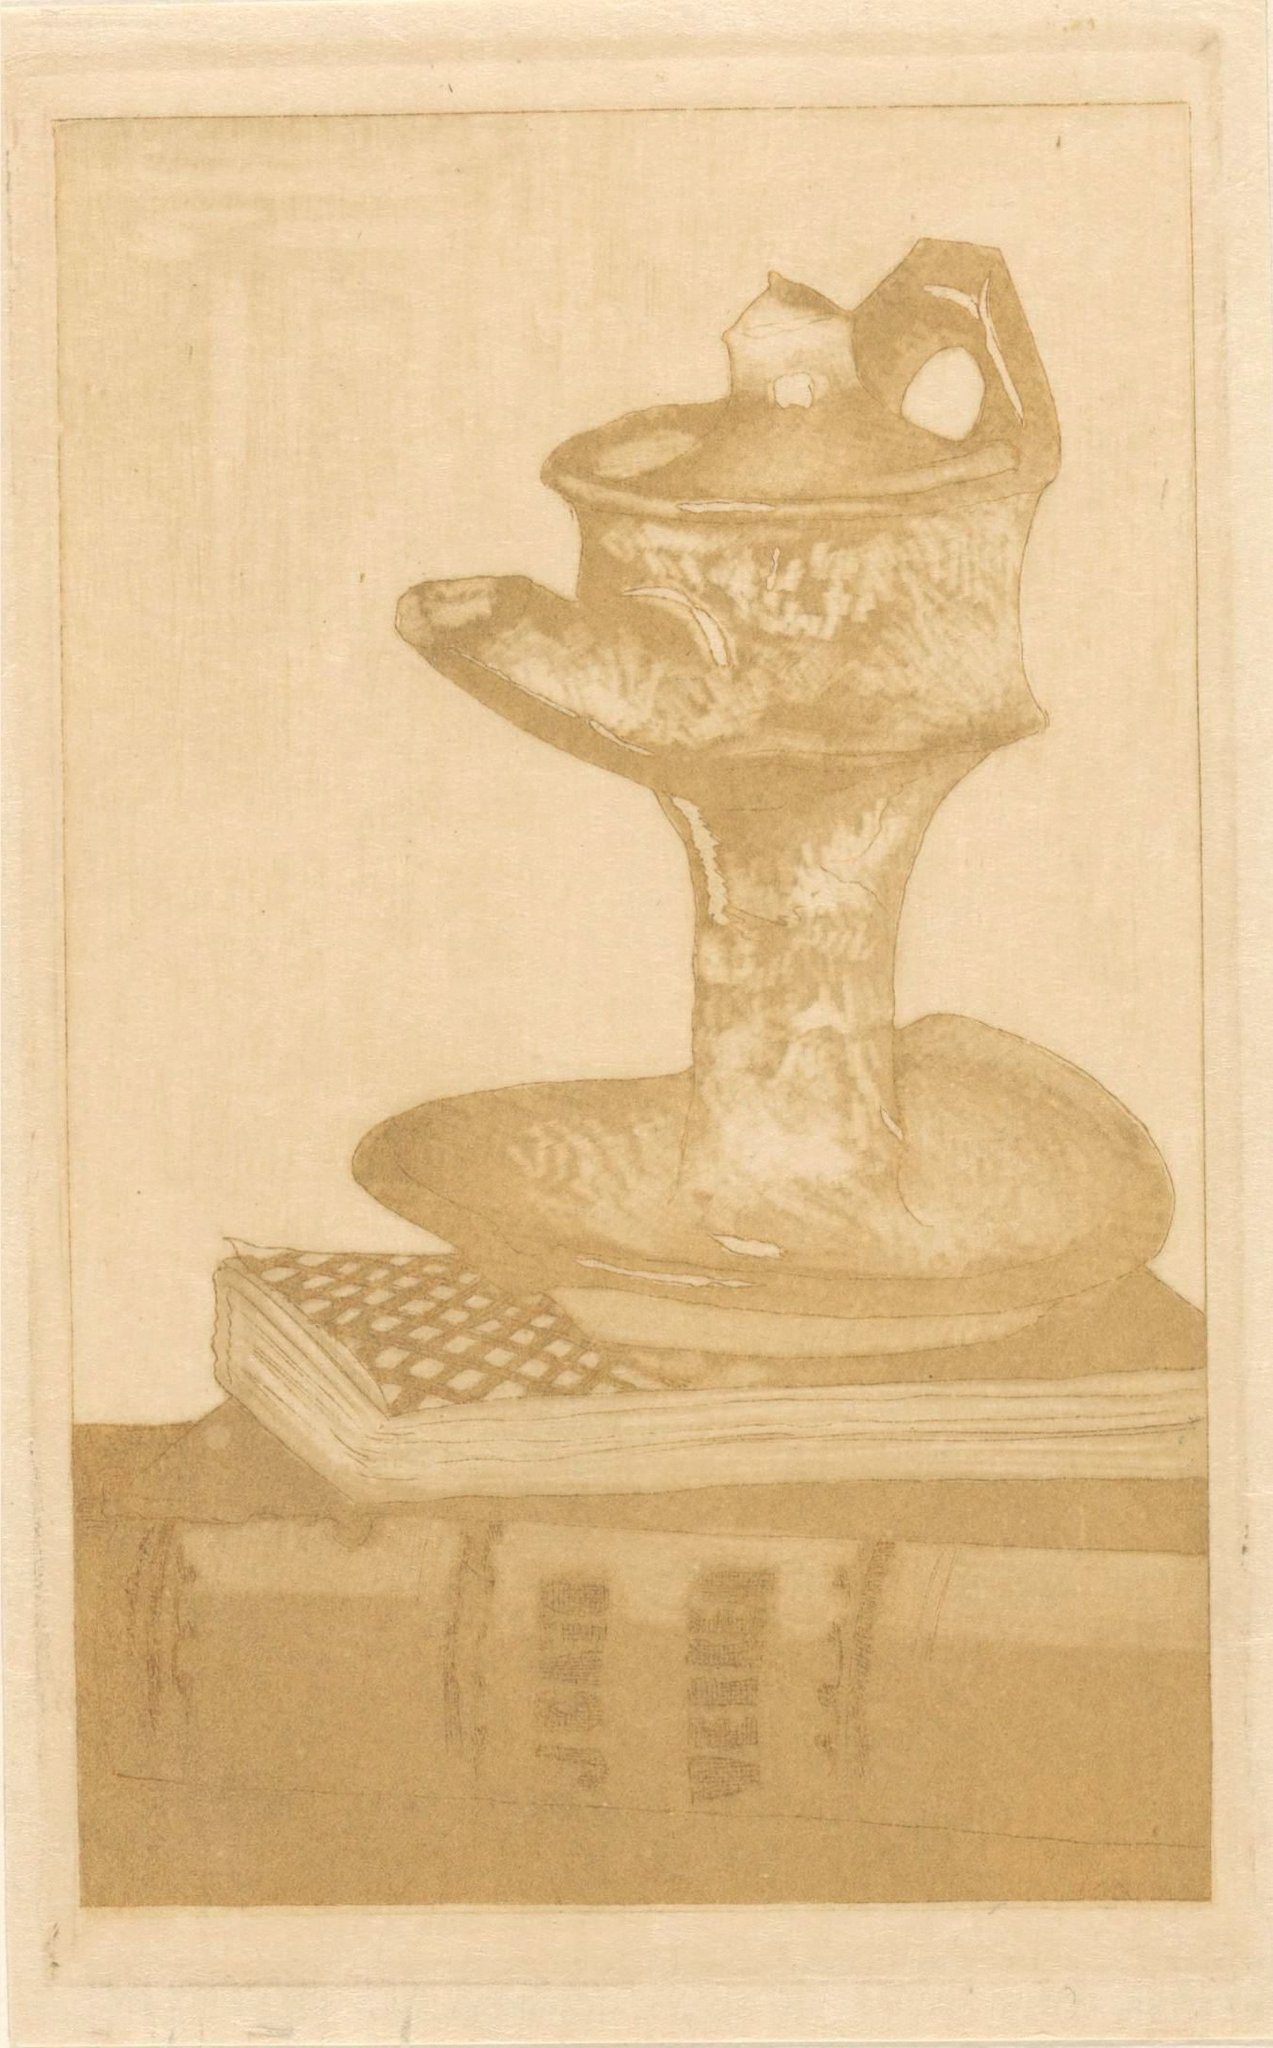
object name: print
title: Stilleven met schenkkan en boeken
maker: frans everbag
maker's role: draughtsman, print maker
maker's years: 1877-1947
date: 1914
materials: paper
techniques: aquatint, etching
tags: the hague, jacob cats (1577-1660), book, container of ceramics: jar, jug, pot, vase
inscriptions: collector's mark: Lugt 2228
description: Op het onderste boek het opschrift 'J. Cats, Werken', het verzameld werk van dichter, jurist en politicus Jacob Cats.